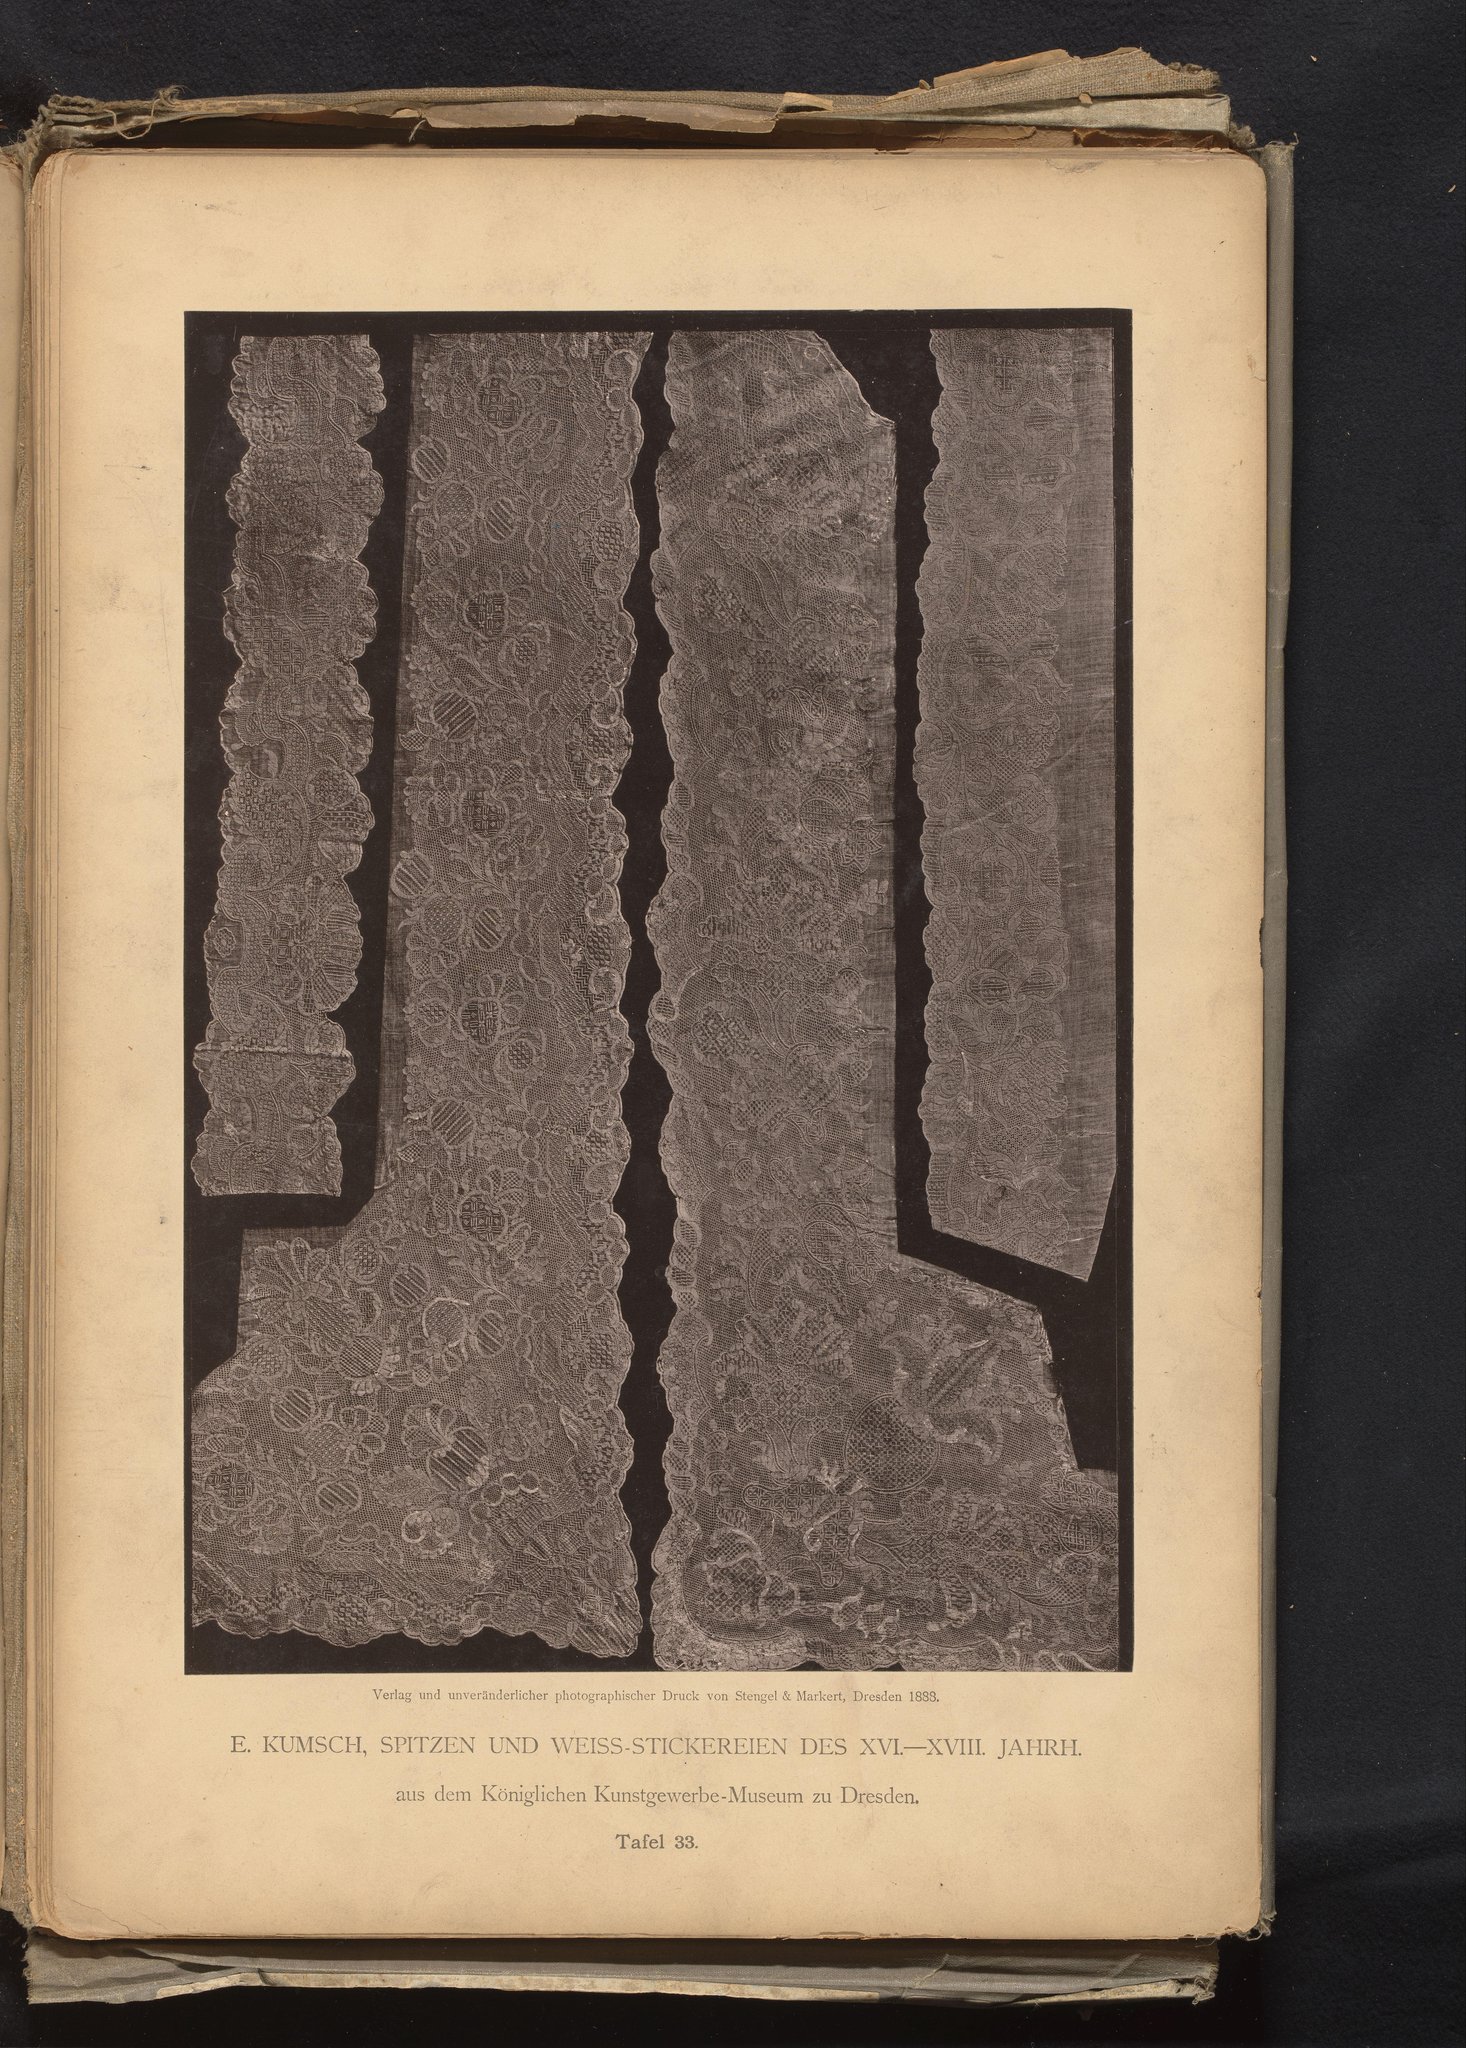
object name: photomechanical print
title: Vier stukken Duits kant uit circa 1770, uit de collectie van het Kunstgewerbemuseum in Dresden, Duitsland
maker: Anonymous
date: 1888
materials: paper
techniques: photograph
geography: dresden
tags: lace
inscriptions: inscription: ‘E. KUMSCH, SPITZEN UND WEISS-STICKEREIEN DES XVI.-XVIII. JAHRH./ aus dem Königlichen Kunstgewerbe-Museum zu Dresden’, number: ‘Tafel 33.’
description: Deze prent maakt deel uit van een omslag met 49 prenten en een lijst van afbeeldingen.